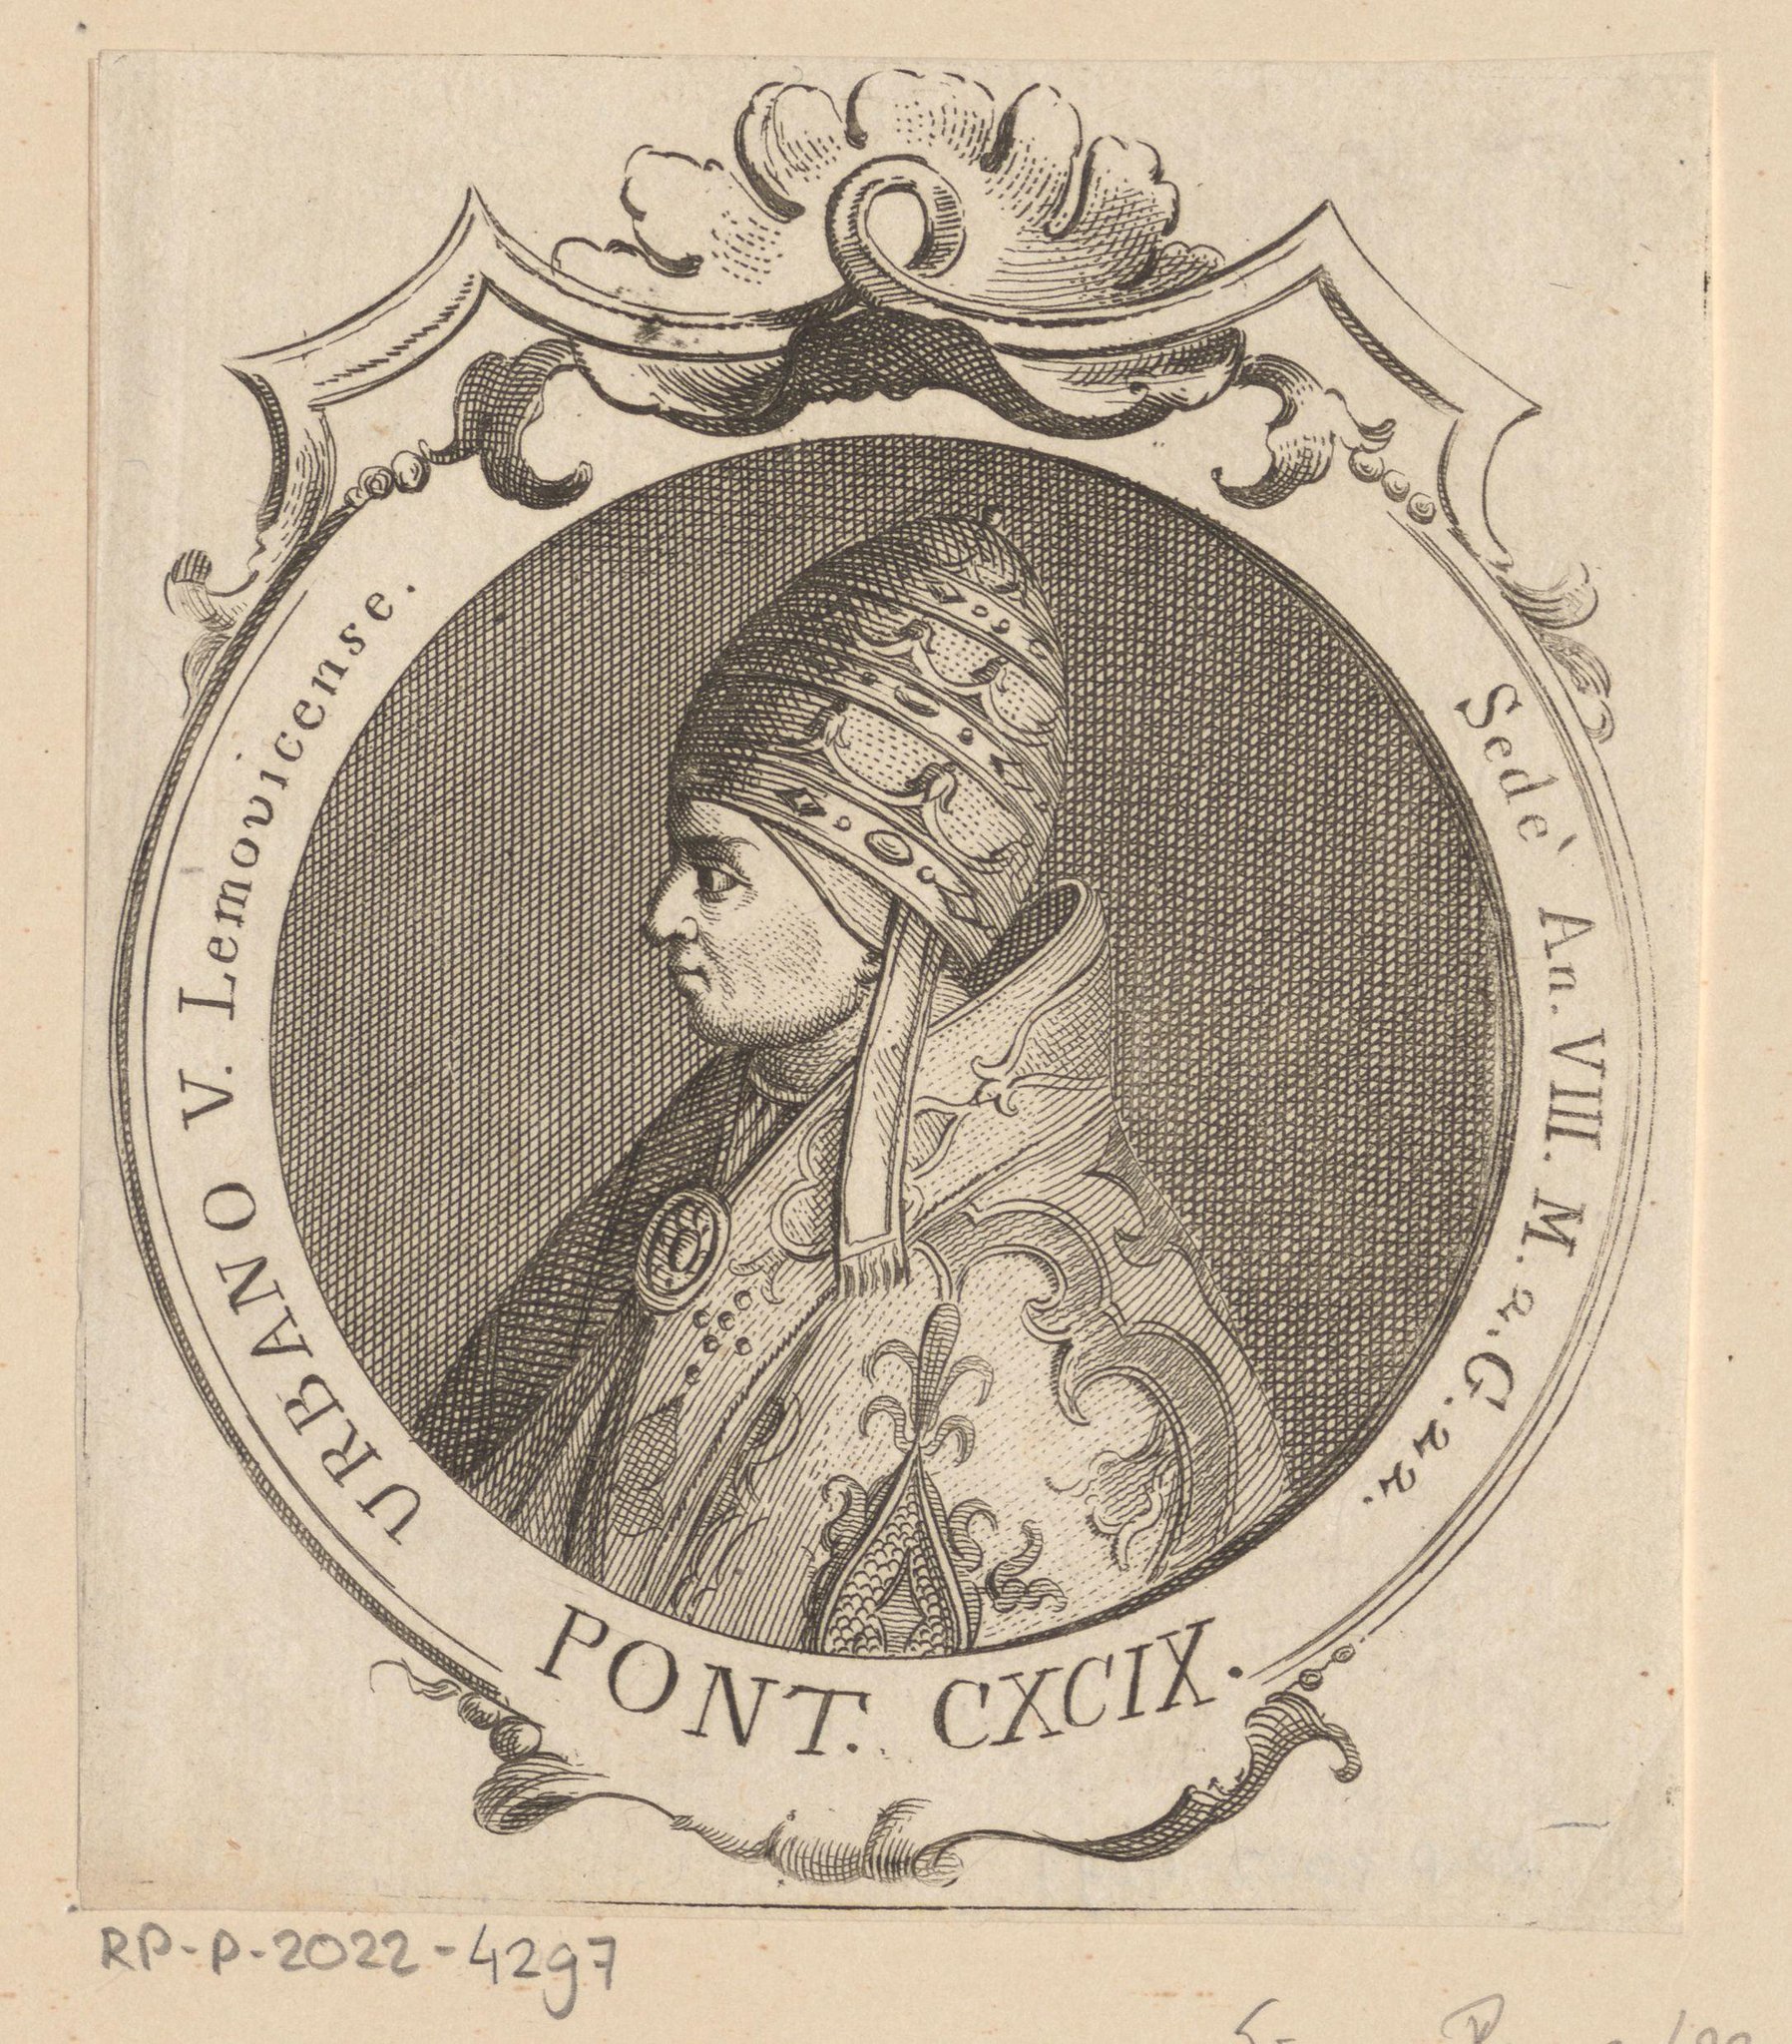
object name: print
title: Portret van paus Urbanus V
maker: Anonymous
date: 1763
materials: paper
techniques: etching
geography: italy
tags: historical persons, pope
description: Prent met tekst in boekdruk op verso gebruikt in: Platina, Bartolommeo. Storia delle vite de' Pontefici di Bartolommeo Platina e d'altri autori (...). Venetië: Domenico Ferrarin, 1763, dl. 3, p. 239.